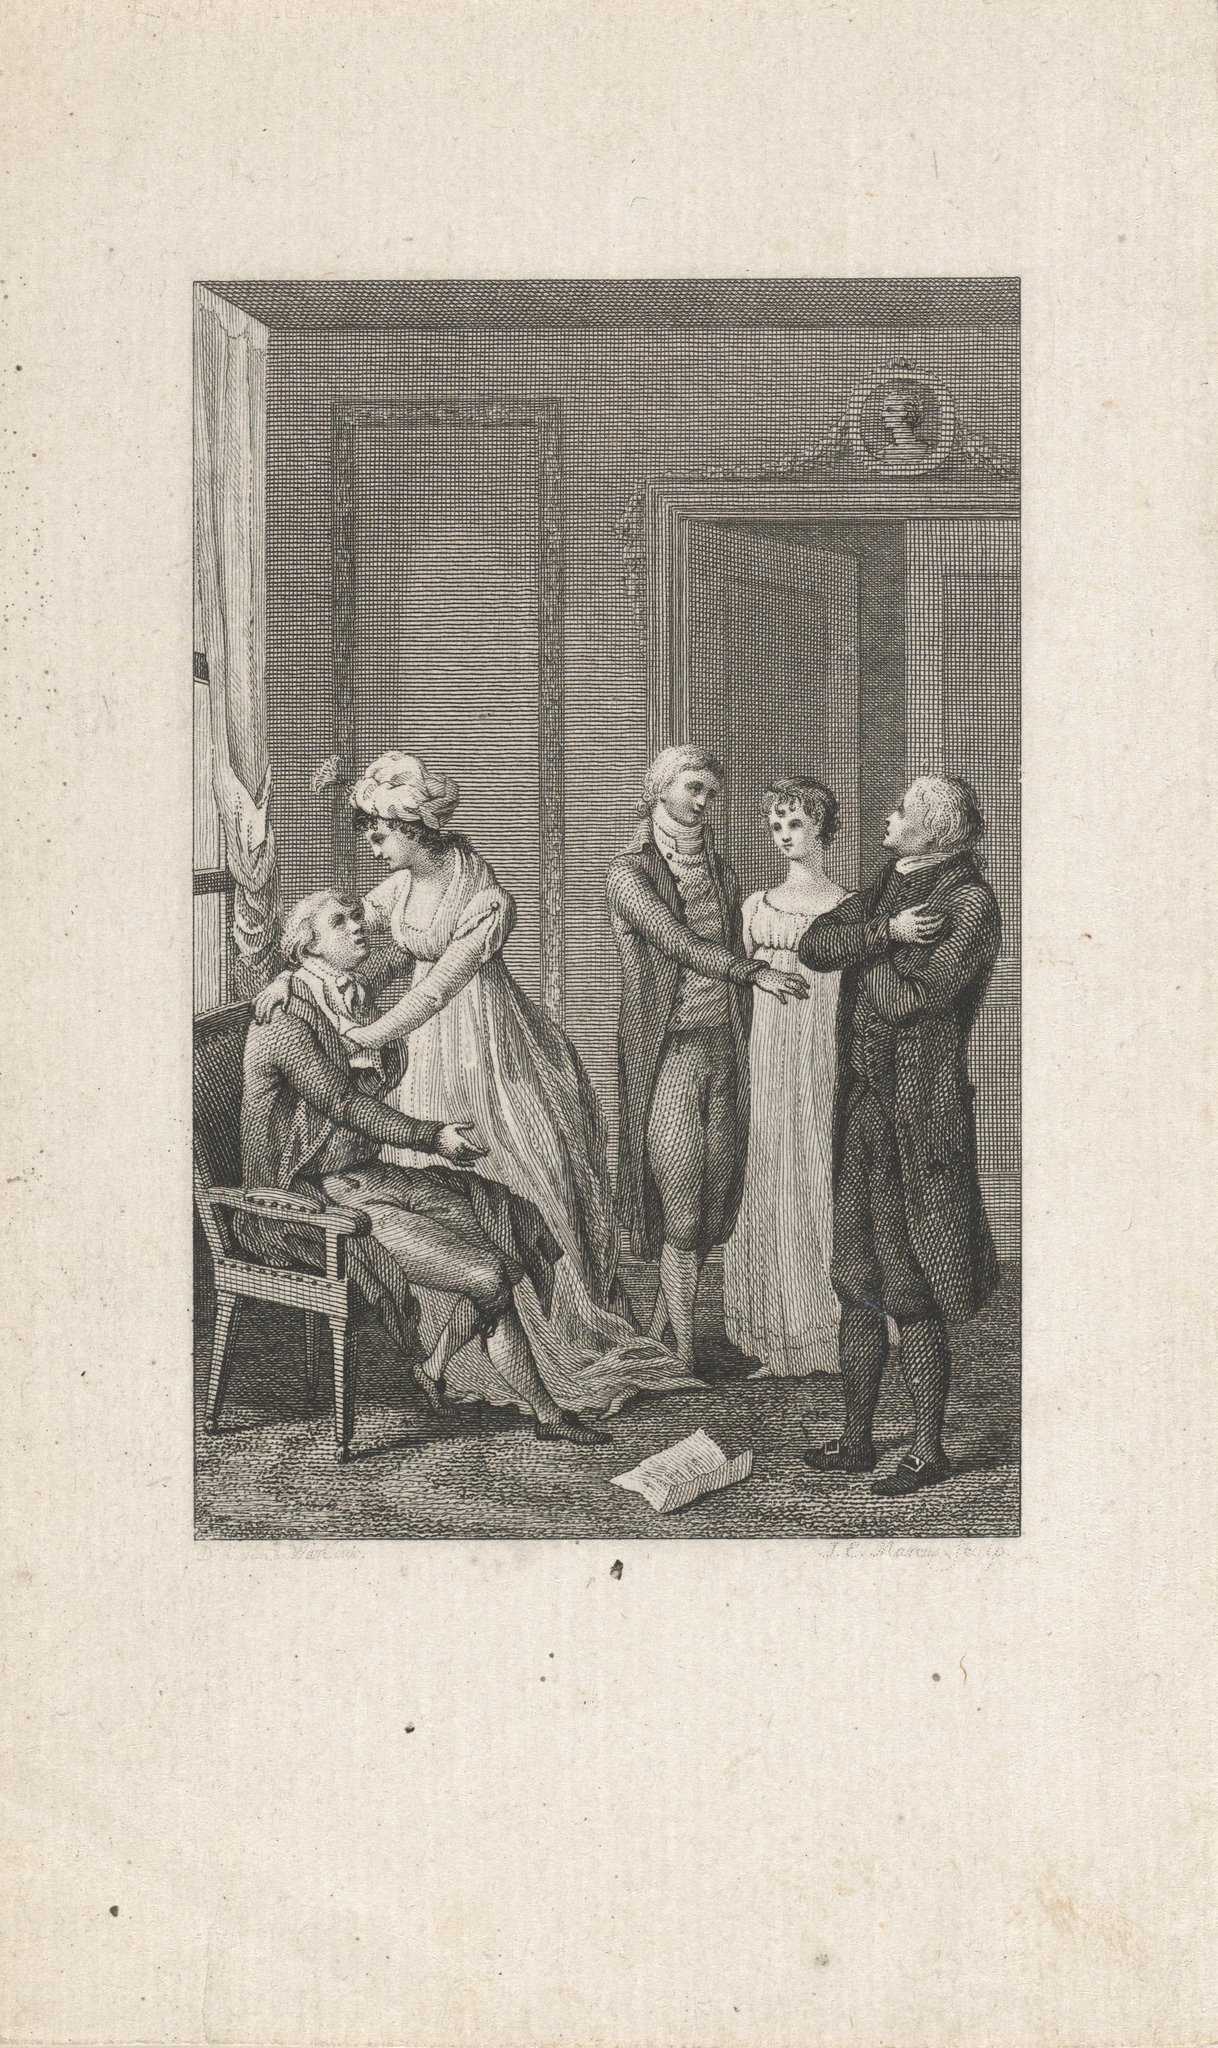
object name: print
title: Vijf figuren in een interieur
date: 1784-1826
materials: paper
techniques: etching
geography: amsterdam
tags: postures and gestures of arm(s) and hand(s) in relation to another person - aa - both arms or hands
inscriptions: collector's mark: Lugt 2228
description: Drie heren en twee dames in een interieur. Links heeft een vrouw een hand om de schouders van een in een stoel zittende man en haar andere hand in zijn bovenkleding.